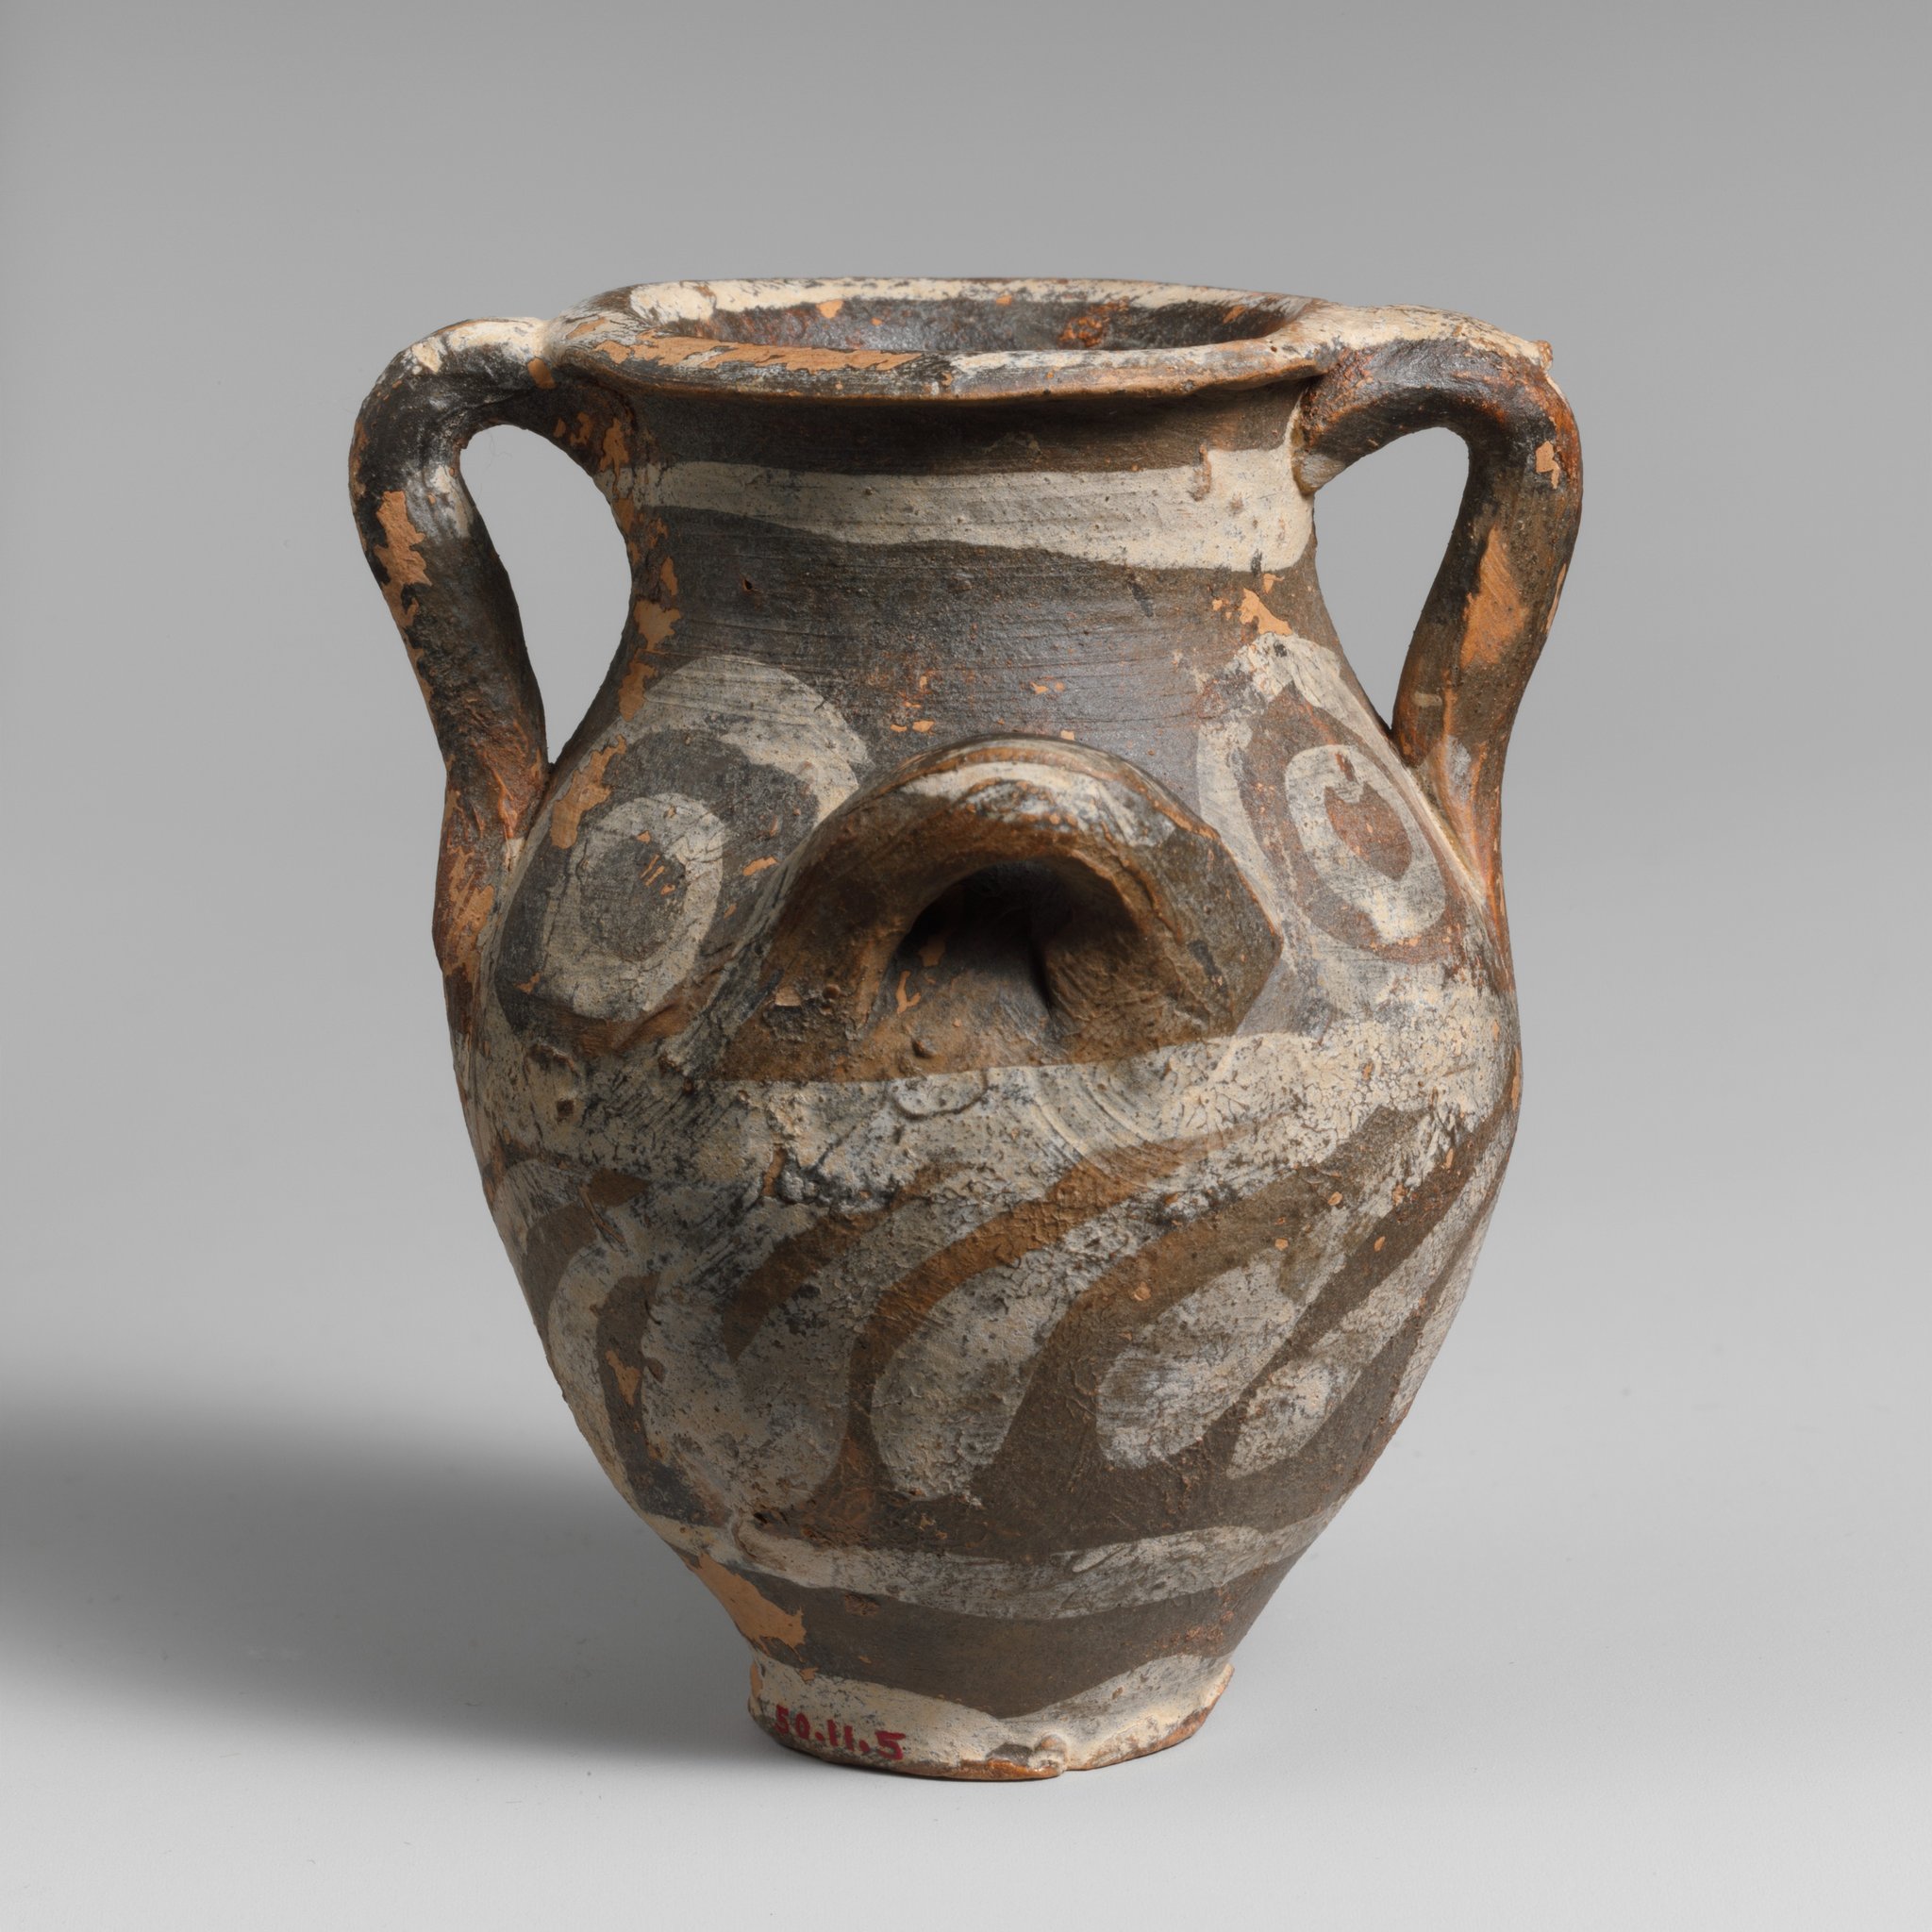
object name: jar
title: Small terracotta jar with four handles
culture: minoan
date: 1800-1750 BCE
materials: terracotta